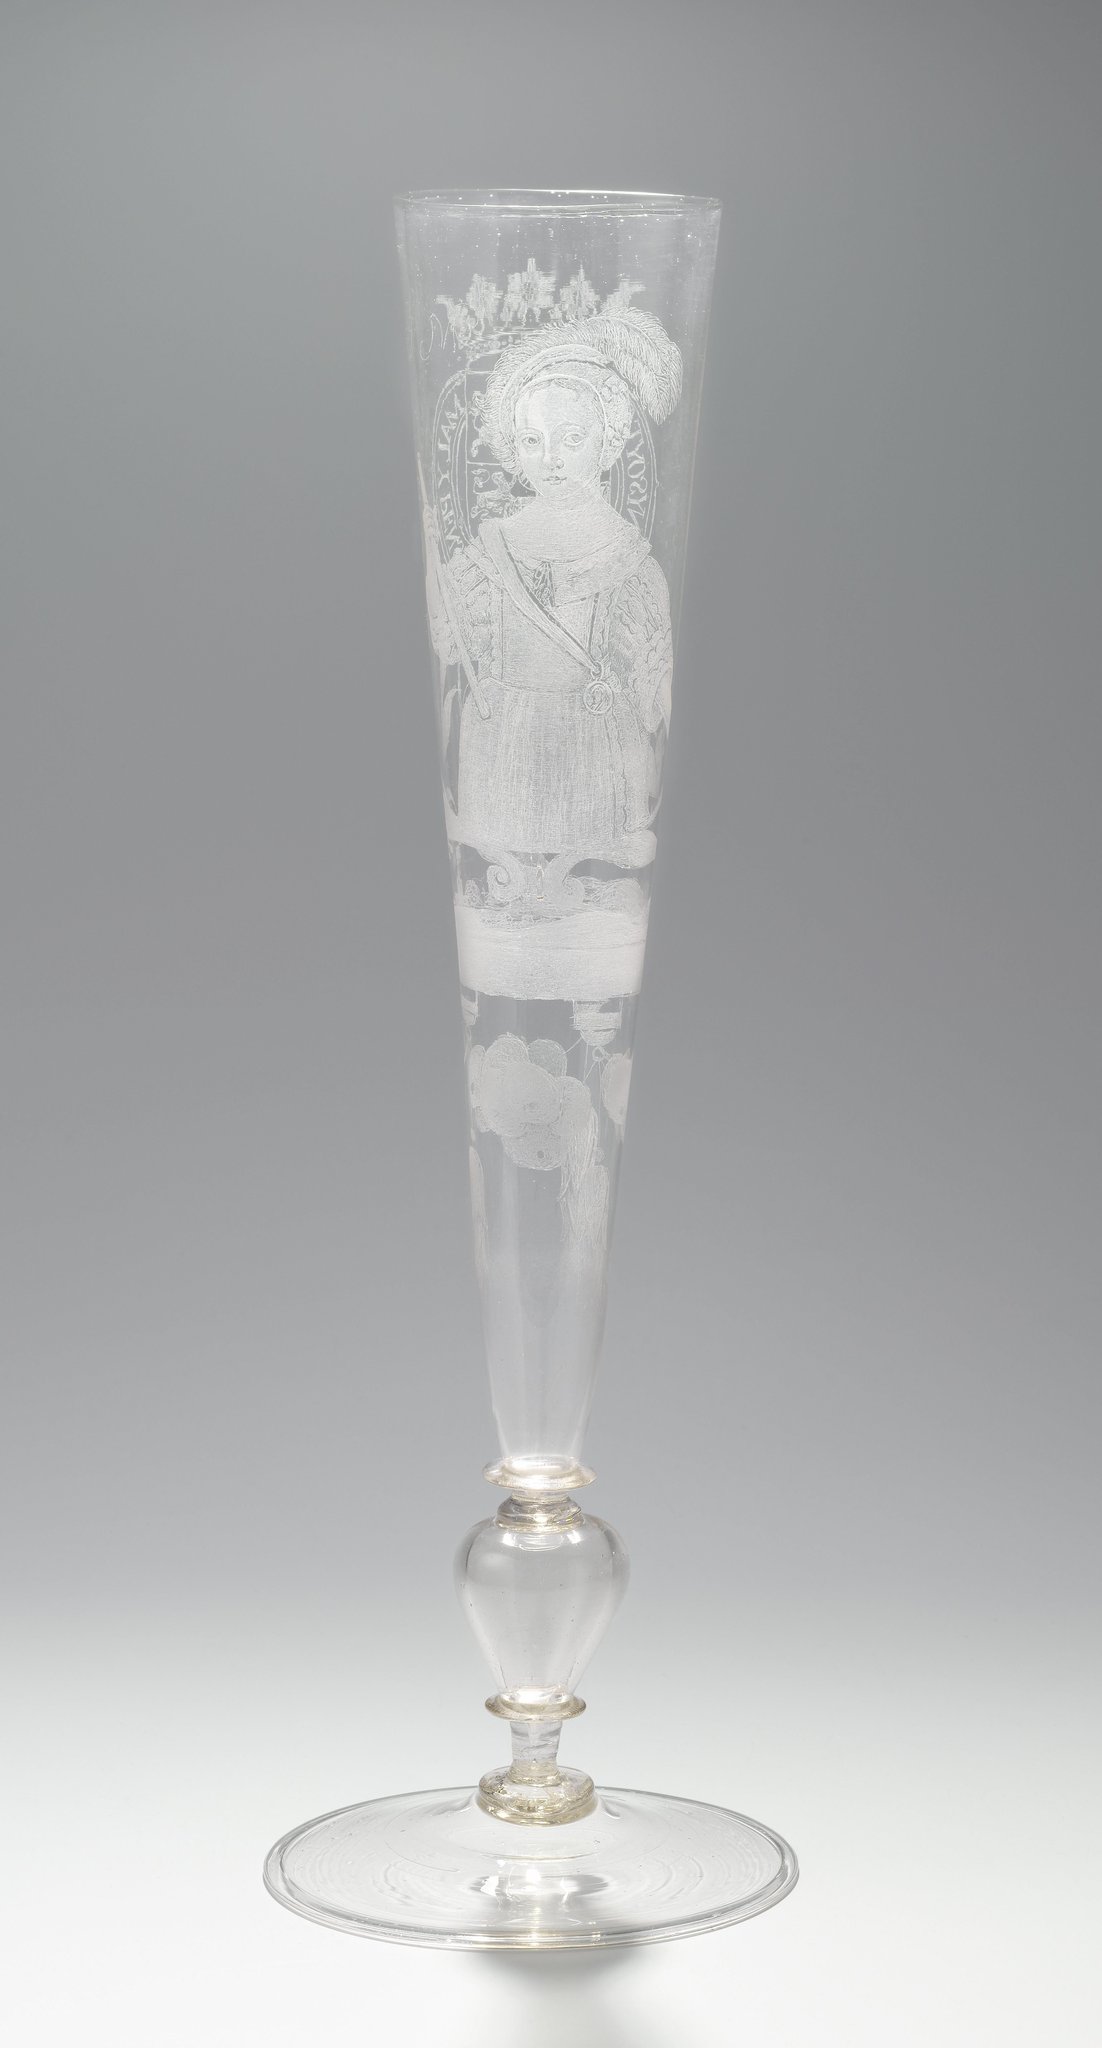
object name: flute glass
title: Flute glass with a portrait of William III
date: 1655-1660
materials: glass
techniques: diamond point engraving, glassblowing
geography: northern netherlands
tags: the hague, william iii (prince of orange and king of england, scotland, and ireland), coat of arms (symbol of sovereignty), historical persons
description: Prince William III was born in 1650, shortly after the death of his father, Stadtholder-Prince William II. He would not become stadtholder until 1672. Here he is depicted as a young child, with his coat of arms on the back of the glass.